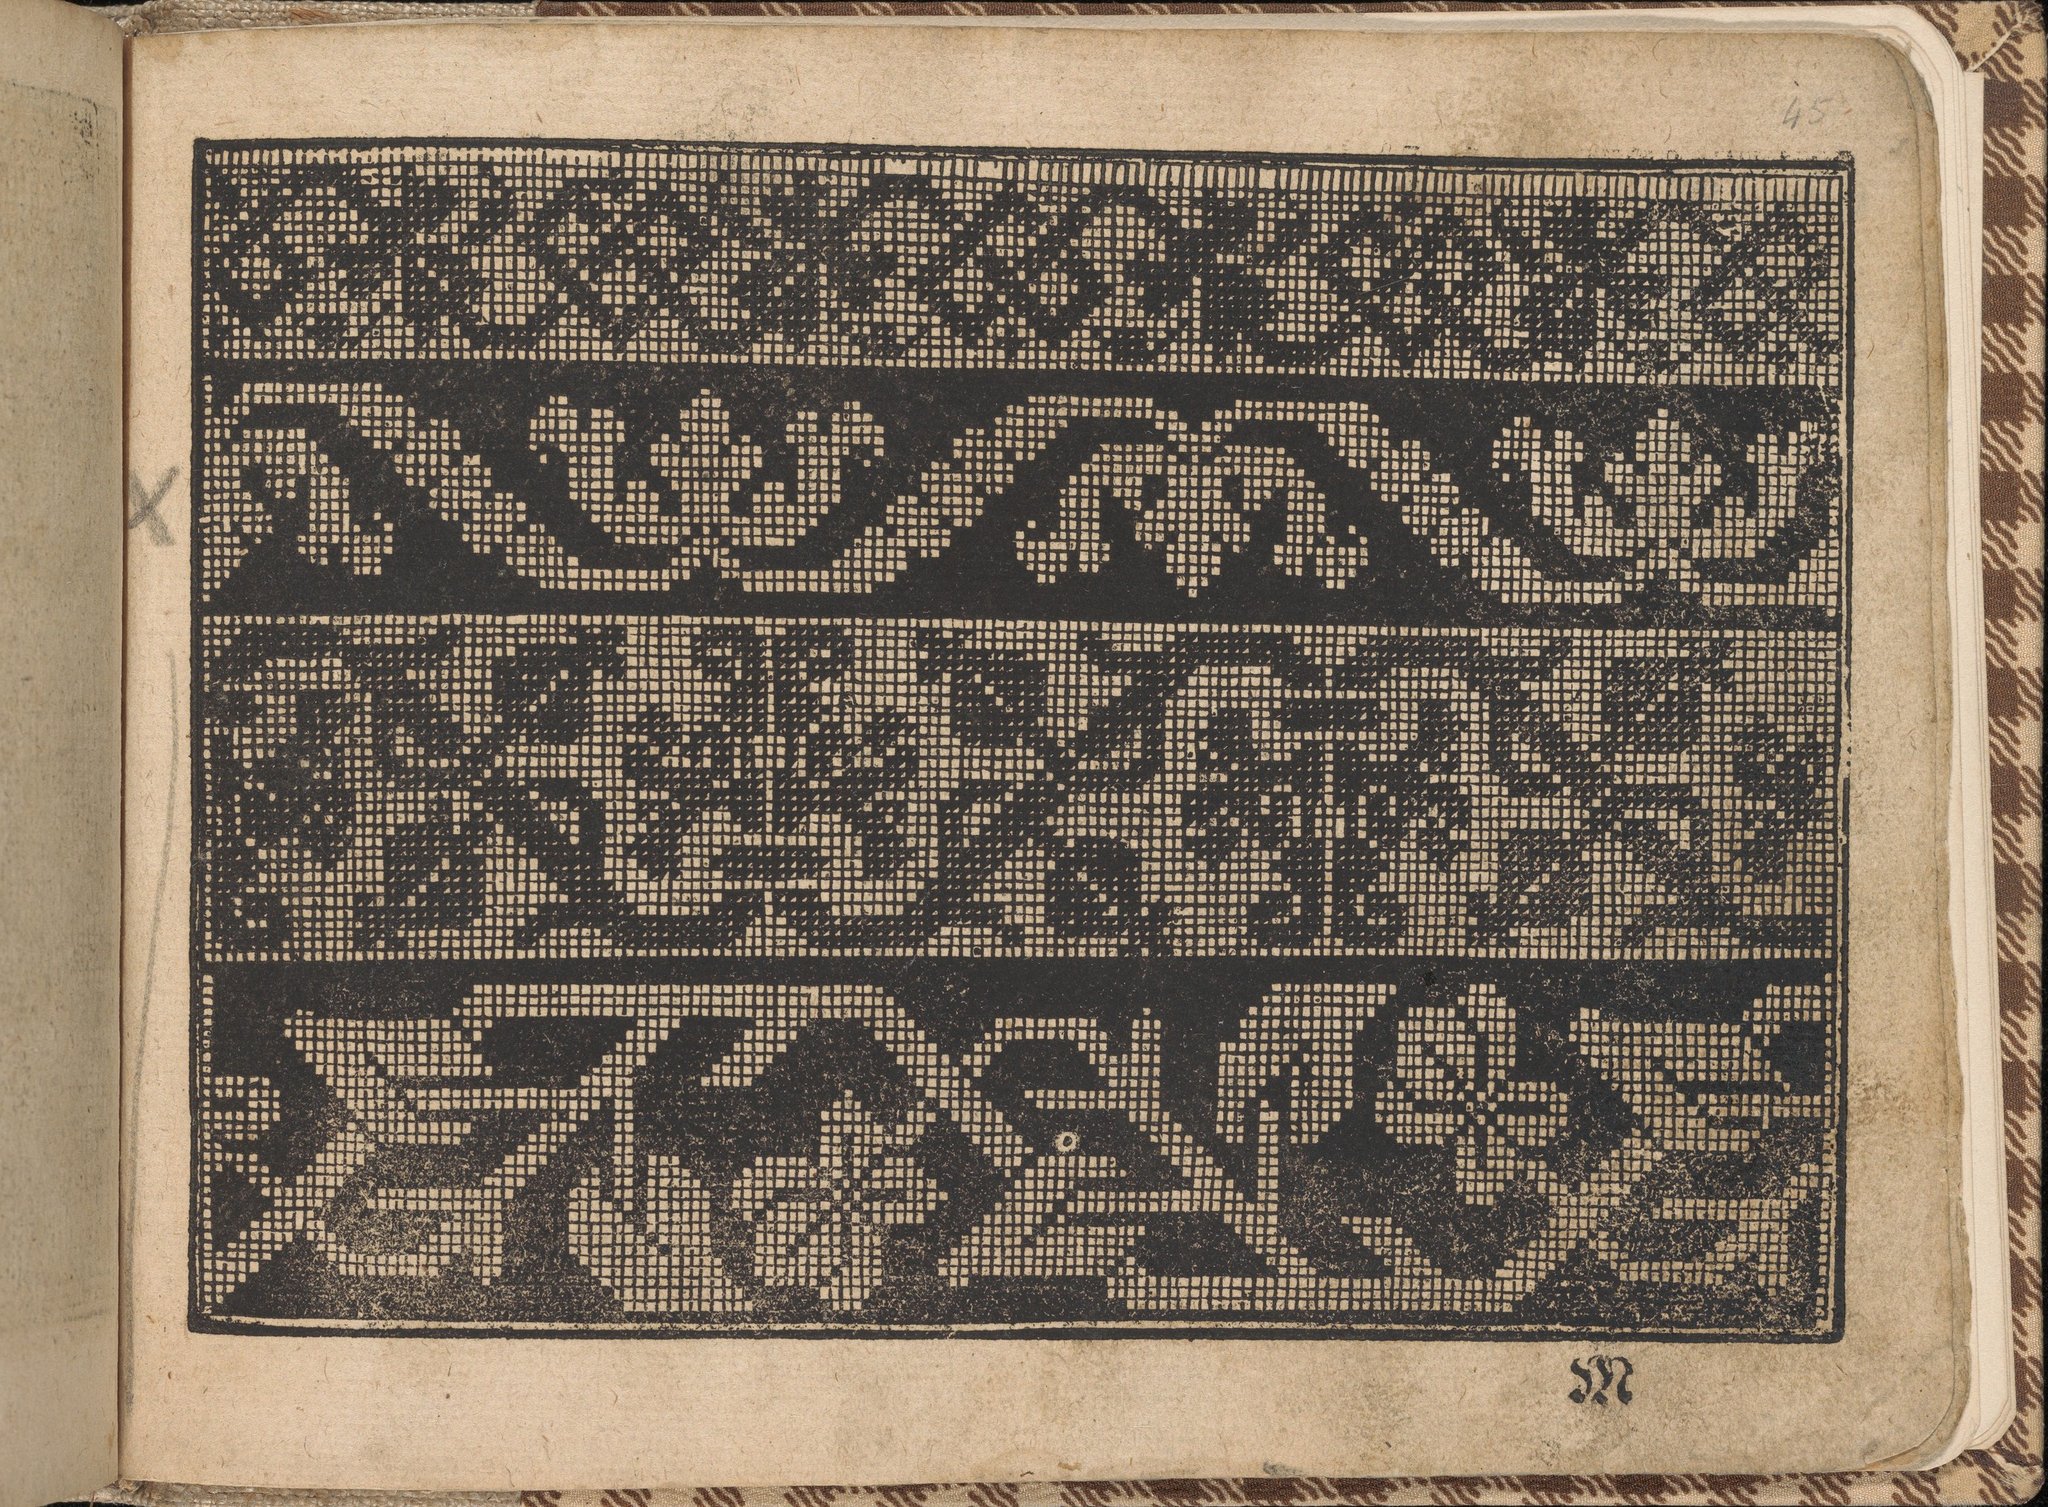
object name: book print ornament architecture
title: New Künstlichs Modelbuch (Page 45 recto)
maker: bernhard jobin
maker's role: publisher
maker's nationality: swiss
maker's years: 1535-1597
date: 1600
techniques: woodcut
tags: ornament